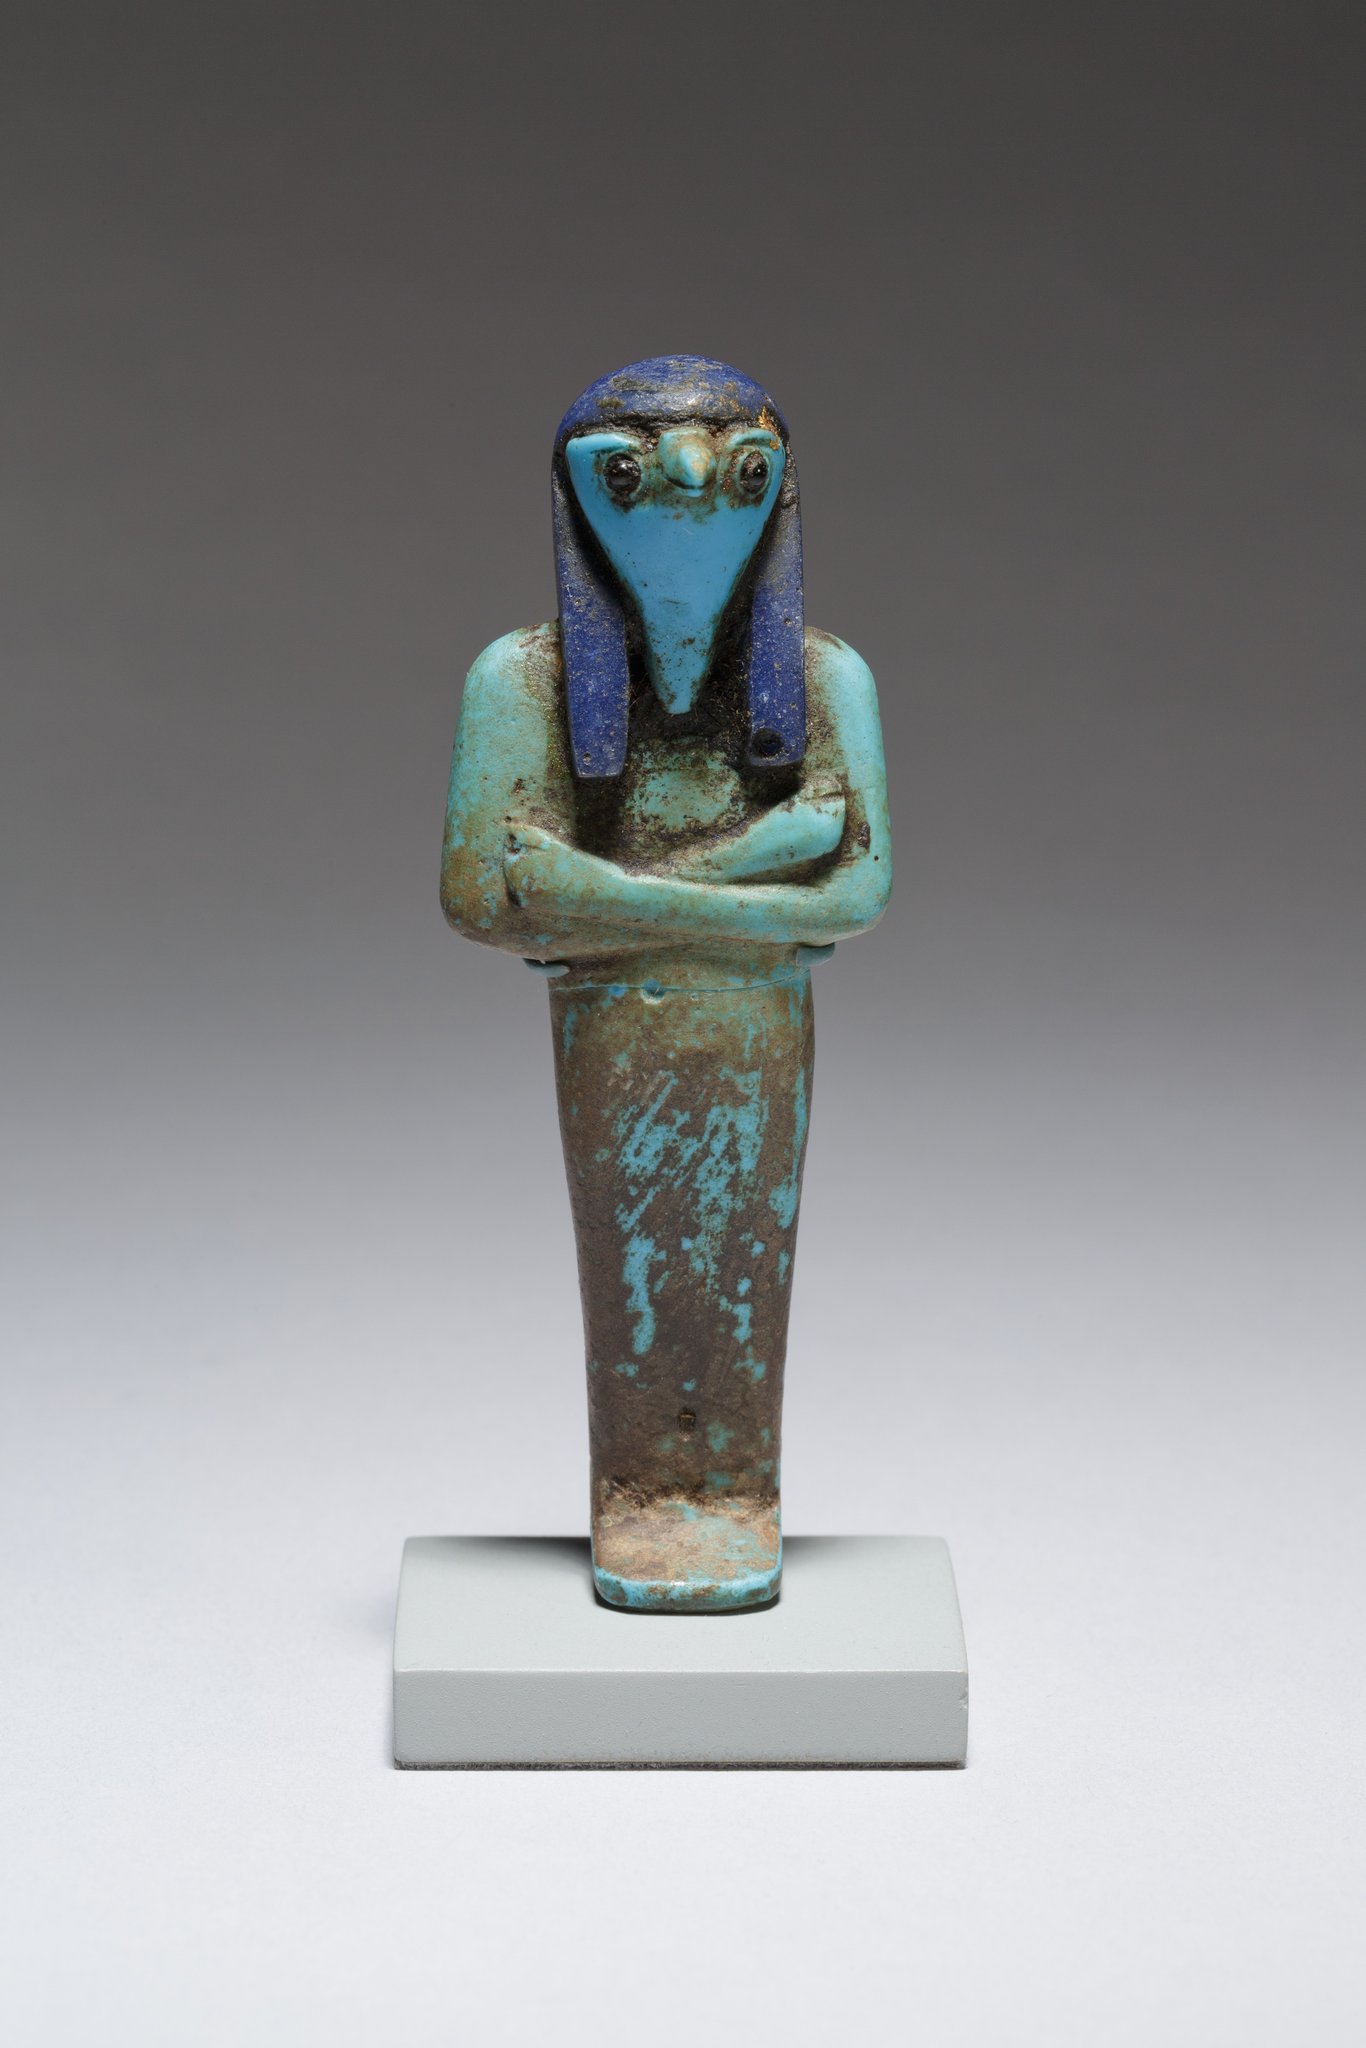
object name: funerary figure, qebehsenuef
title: Funerary figure of Qebehsenuef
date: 1100-332 BCE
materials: glass, metal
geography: egypt